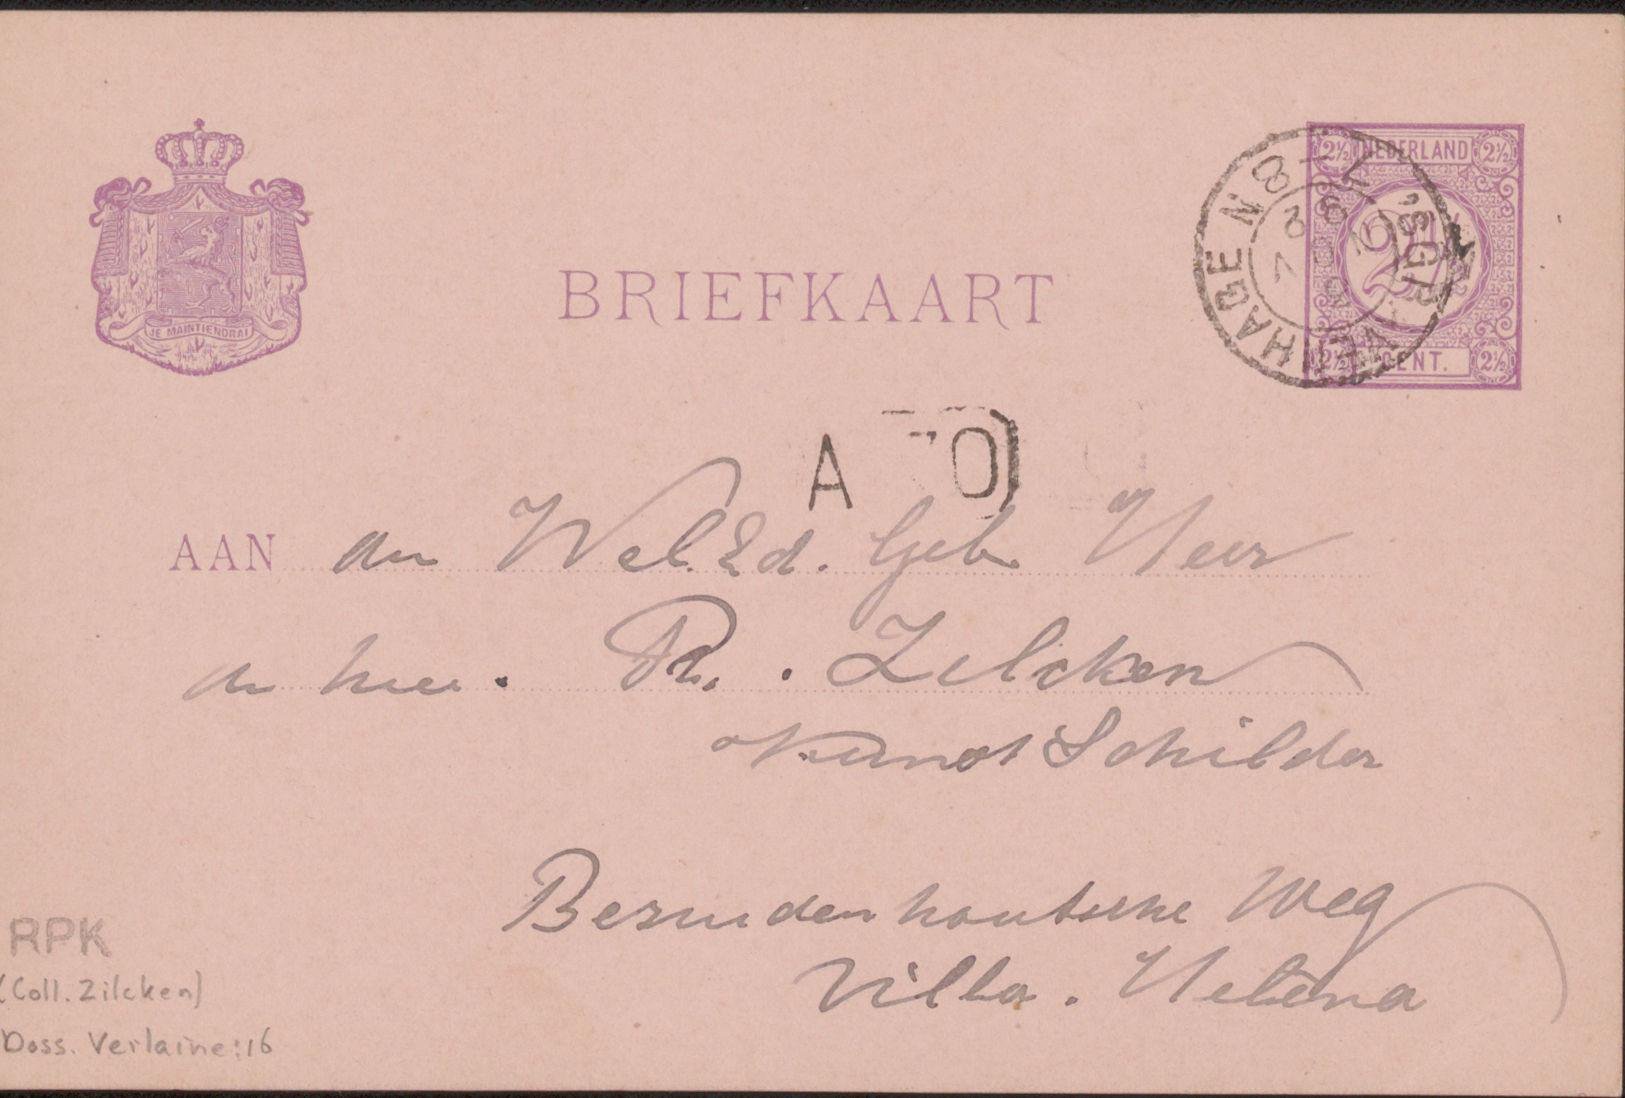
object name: postcard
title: Briefkaart aan Philip Zilcken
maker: jacob maris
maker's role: draughtsman, painter, print maker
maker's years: 1837-1899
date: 1892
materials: cardboard, ink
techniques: pen, writing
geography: the hague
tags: paris, paul verlaine, philip zilcken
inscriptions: collector's mark: ‘RPK’